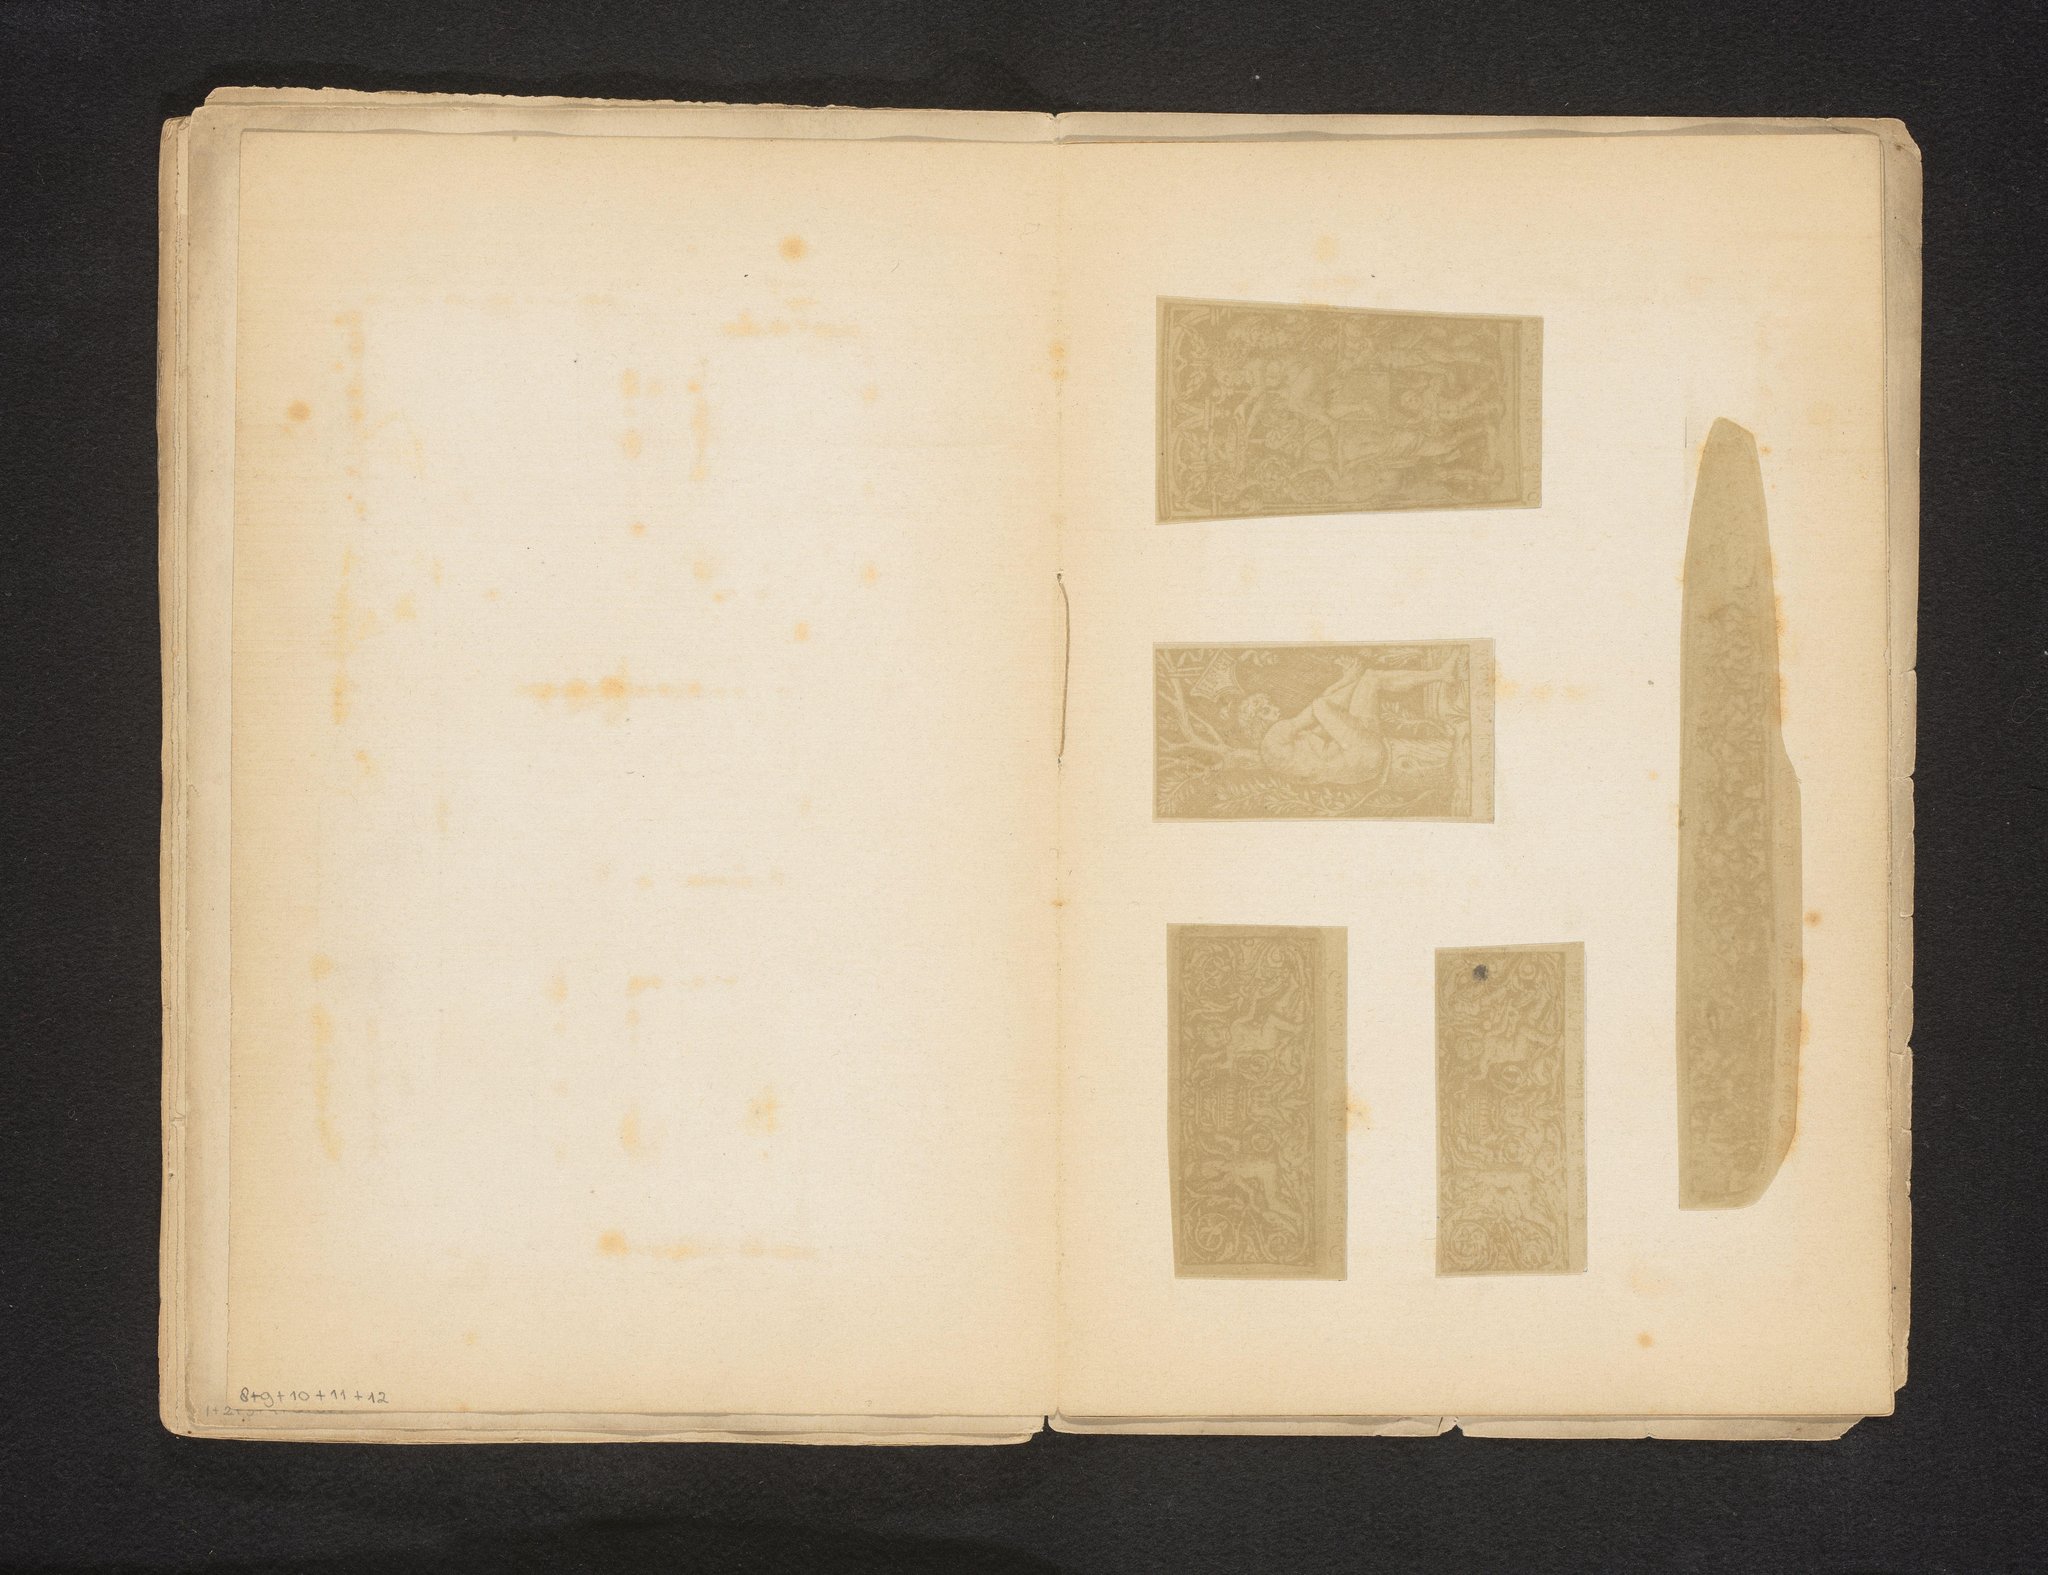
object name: page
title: Fotoreproductie van een prent van groteske ornamenten en twee putti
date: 1852-1857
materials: photographic support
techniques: salted paper print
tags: ornament ~ grotesque, cupids: 'amores', 'amoretti', 'putti'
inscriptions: inscription: ‘Duch. Voyag. p. 327. col. Brisard.’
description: Foto op blad met vijf foto's op vijfde ongenummerde pagina na pagina 60.